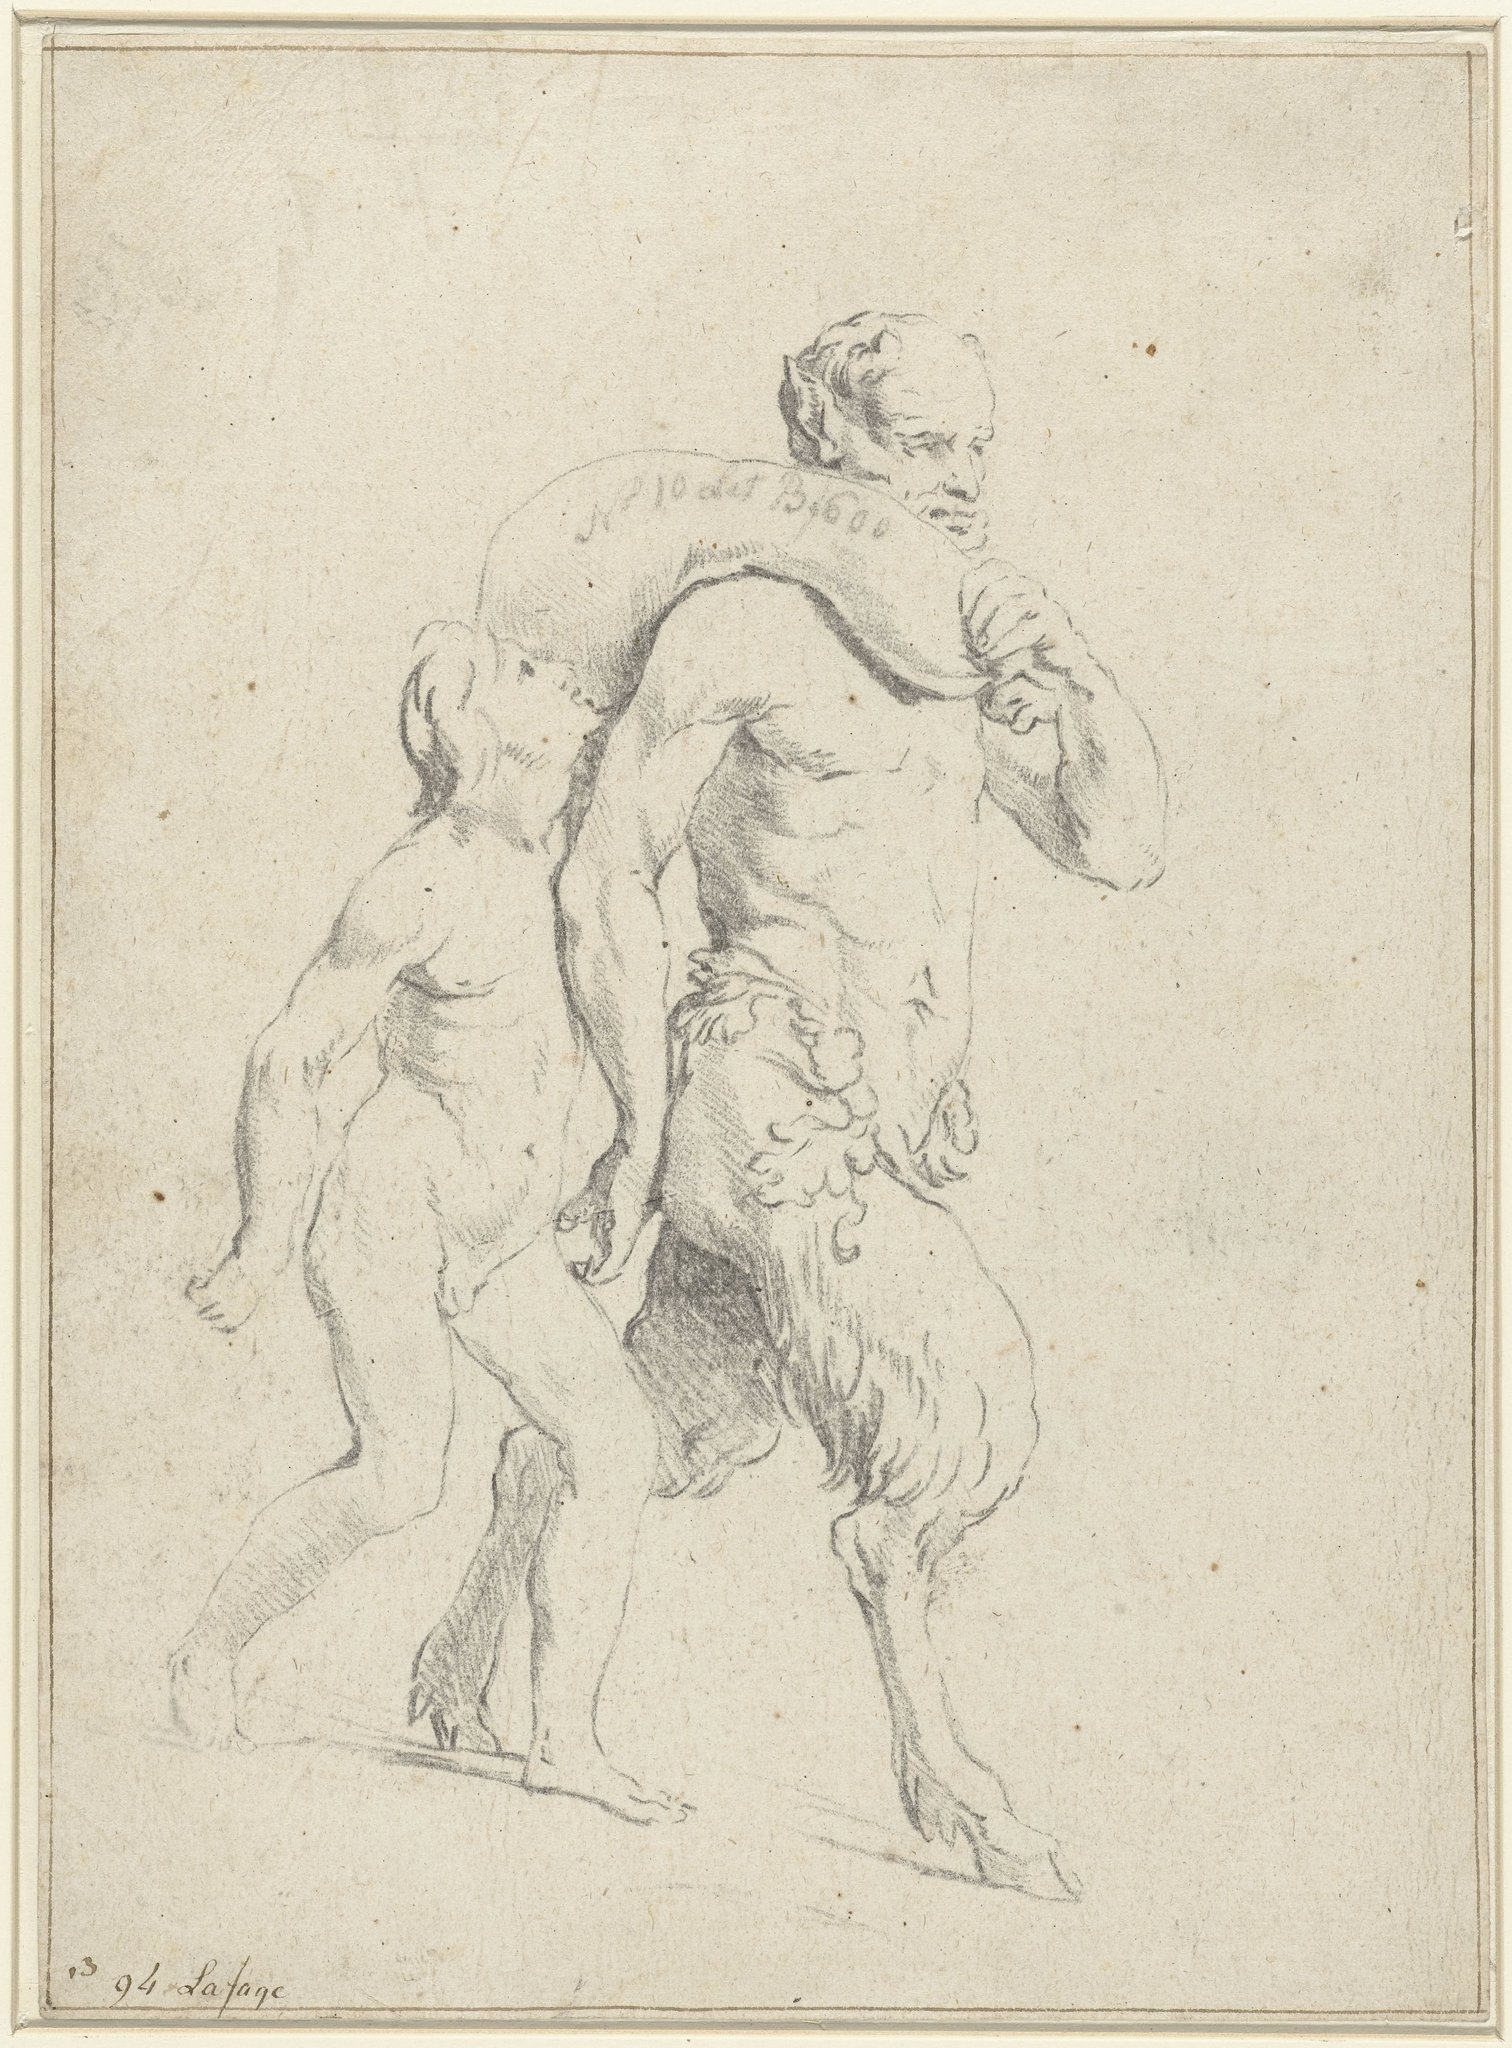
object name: drawing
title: Jongen naast een sater met een zak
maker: Anonymous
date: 1666-1700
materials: chalk, paper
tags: wine ~ alcoholic drinks, satyr(s) (in general)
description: Gaande sater met zak op de rechterschouder, naast hem loopt een jongen.